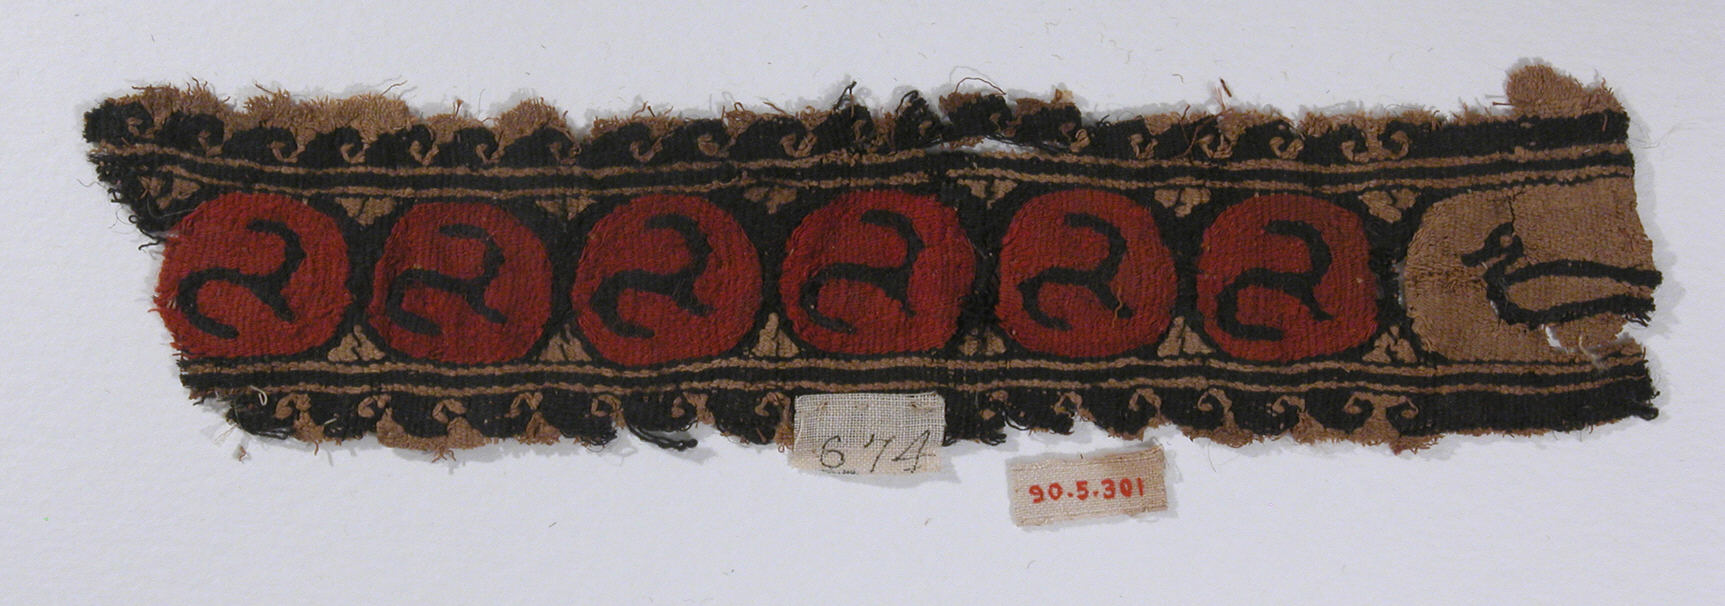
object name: textile fragment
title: Fragment of a Shoulder Band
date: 301-500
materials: linen, wool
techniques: weave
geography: egypt